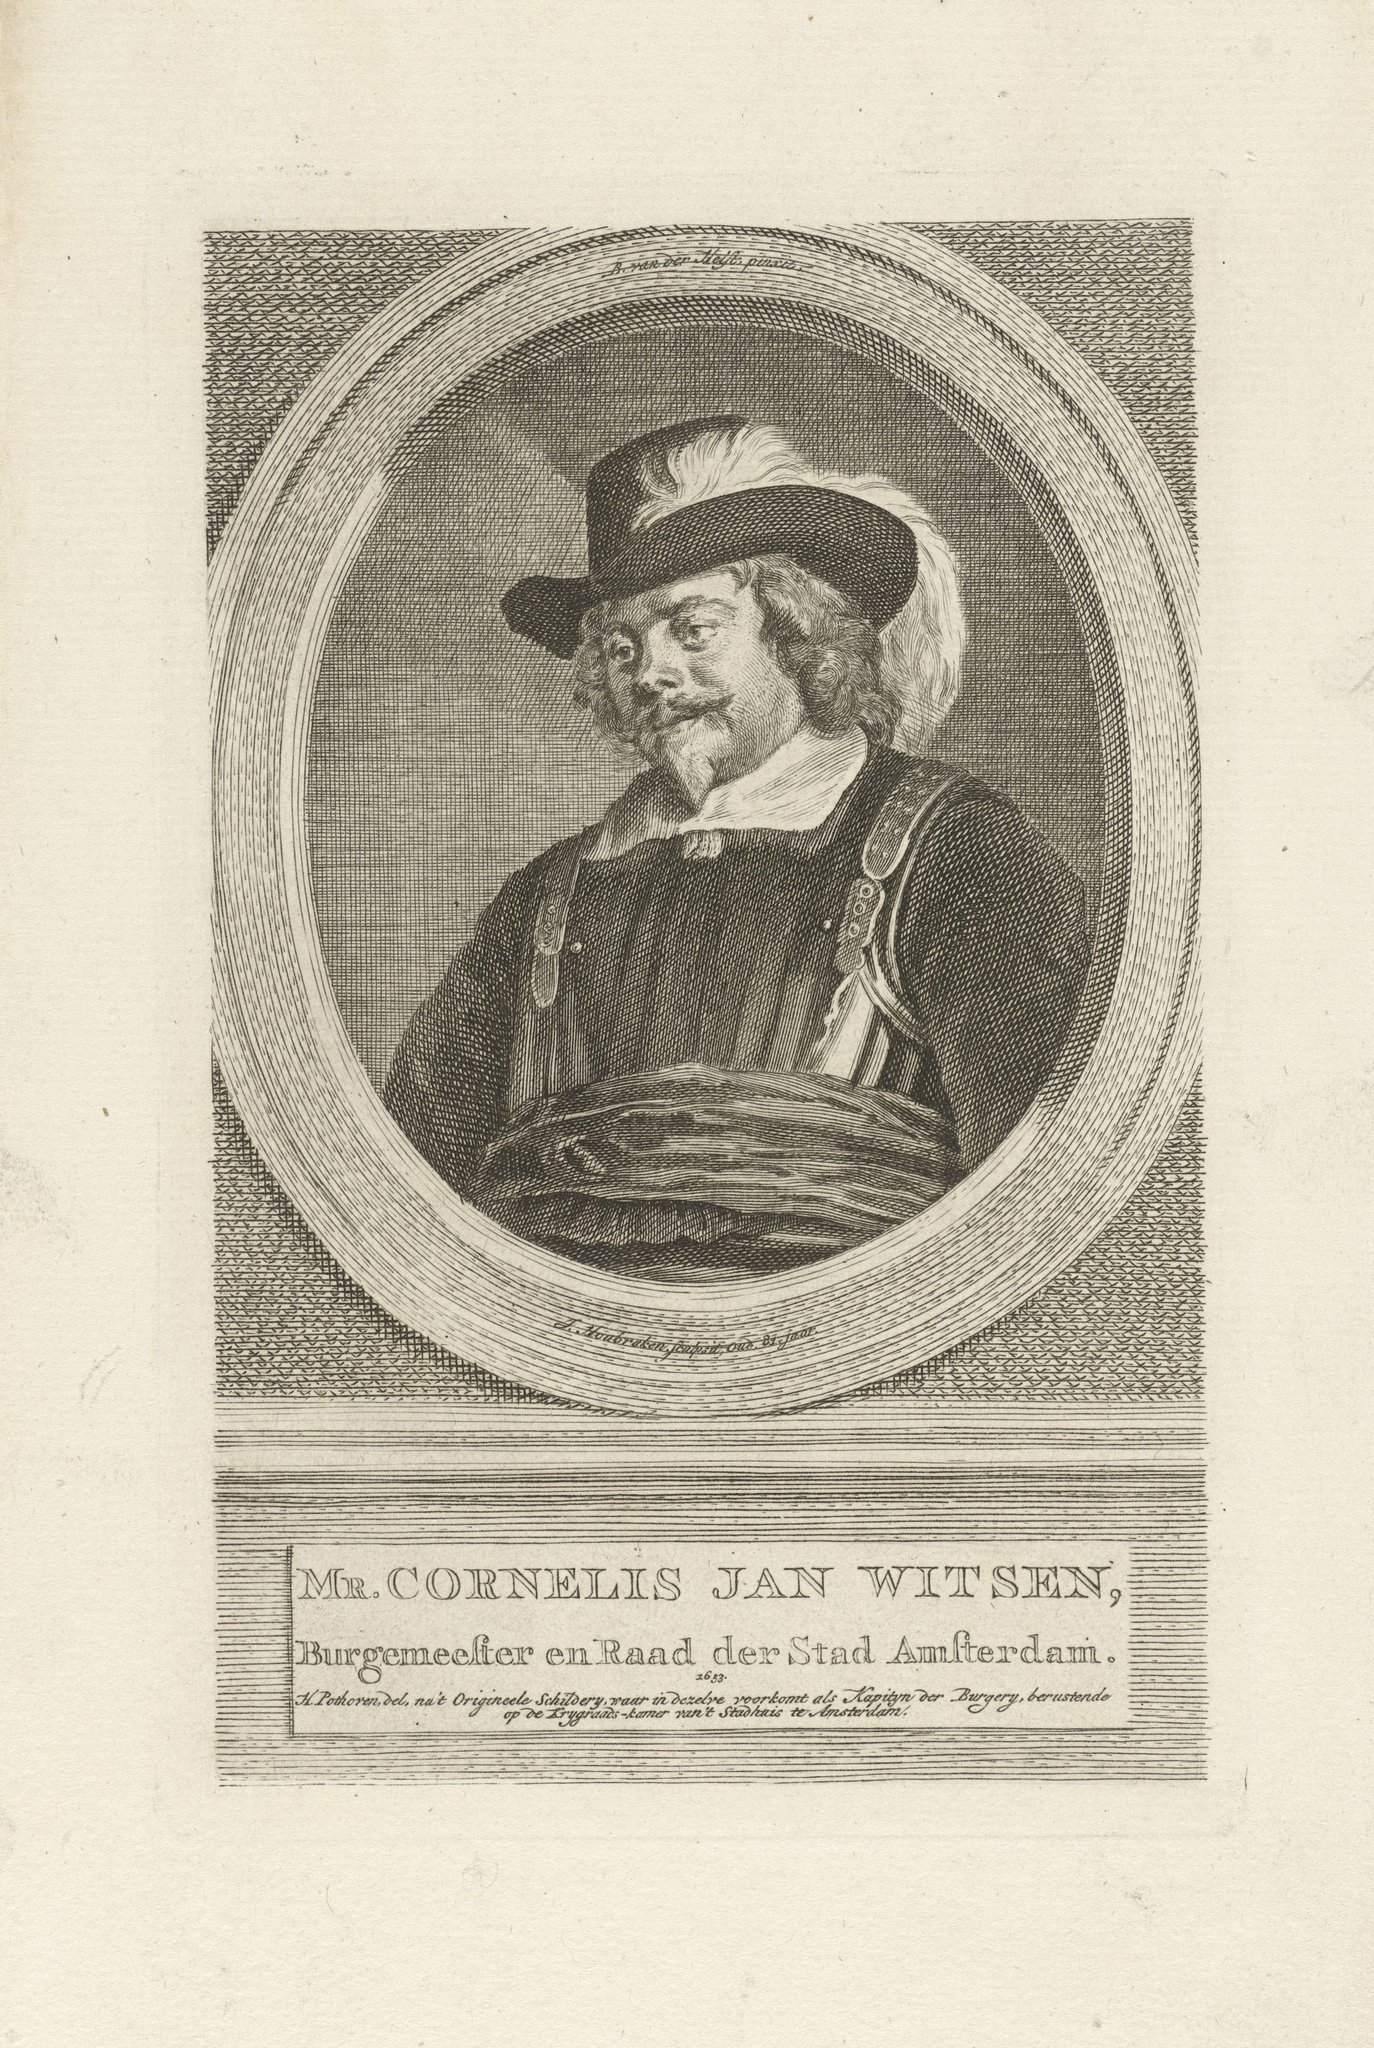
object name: print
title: Portret van Cornelis Witsen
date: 1779-1780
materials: paper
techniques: engraving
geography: amsterdam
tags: amsterdam, mayor, cornelis witsen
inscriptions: collector's mark: Lugt 2228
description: Latere staat prent waarschijnlijk uit: Wagenaar, Jan. Amsterdam in zyne opkomst, aanwas, geschiedenissen, (...). Amsterdam: Isaak Tirion, 1765, vol. 7. De prenten zijn tussen 1765 en 1786 in dit boek gevoegd. Zie: Compleete lyst of register van alle de portraiten en plaaten, (...). Amsterdam: A. van der Kroe en A. Capel, 1786.